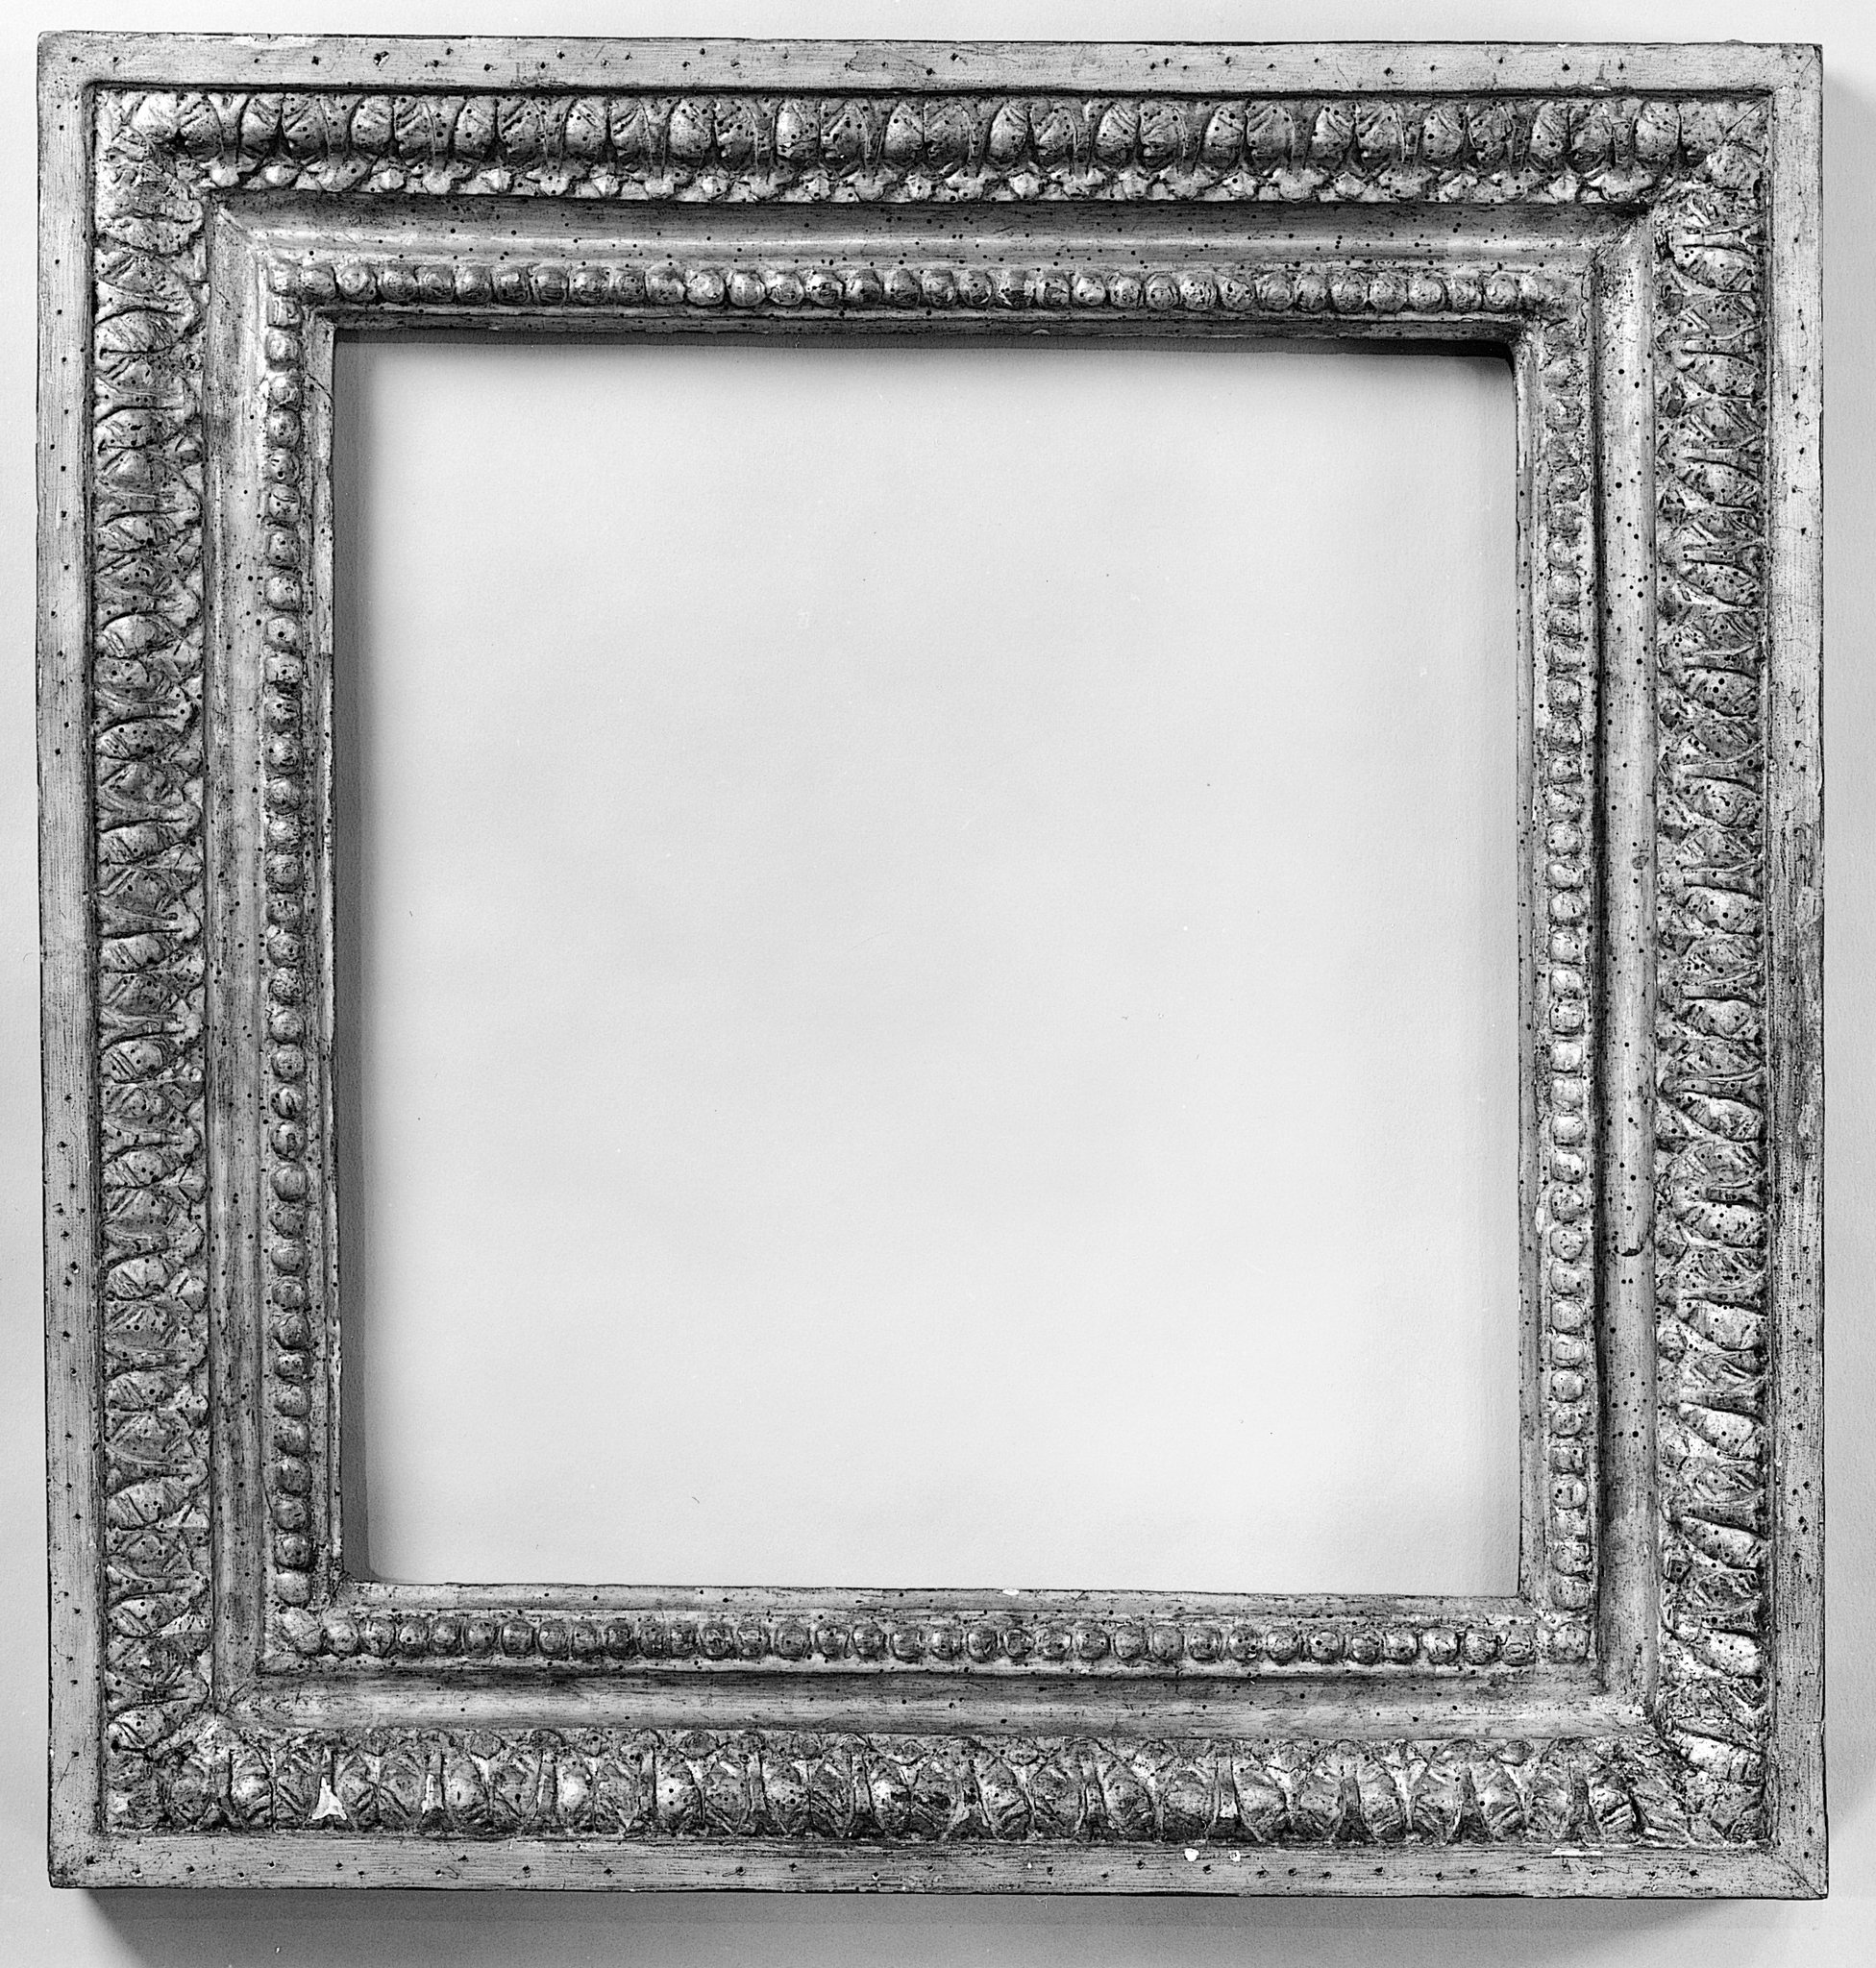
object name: frame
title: Frame made from fragment of architectural molding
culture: italian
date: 1667-1700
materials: wood